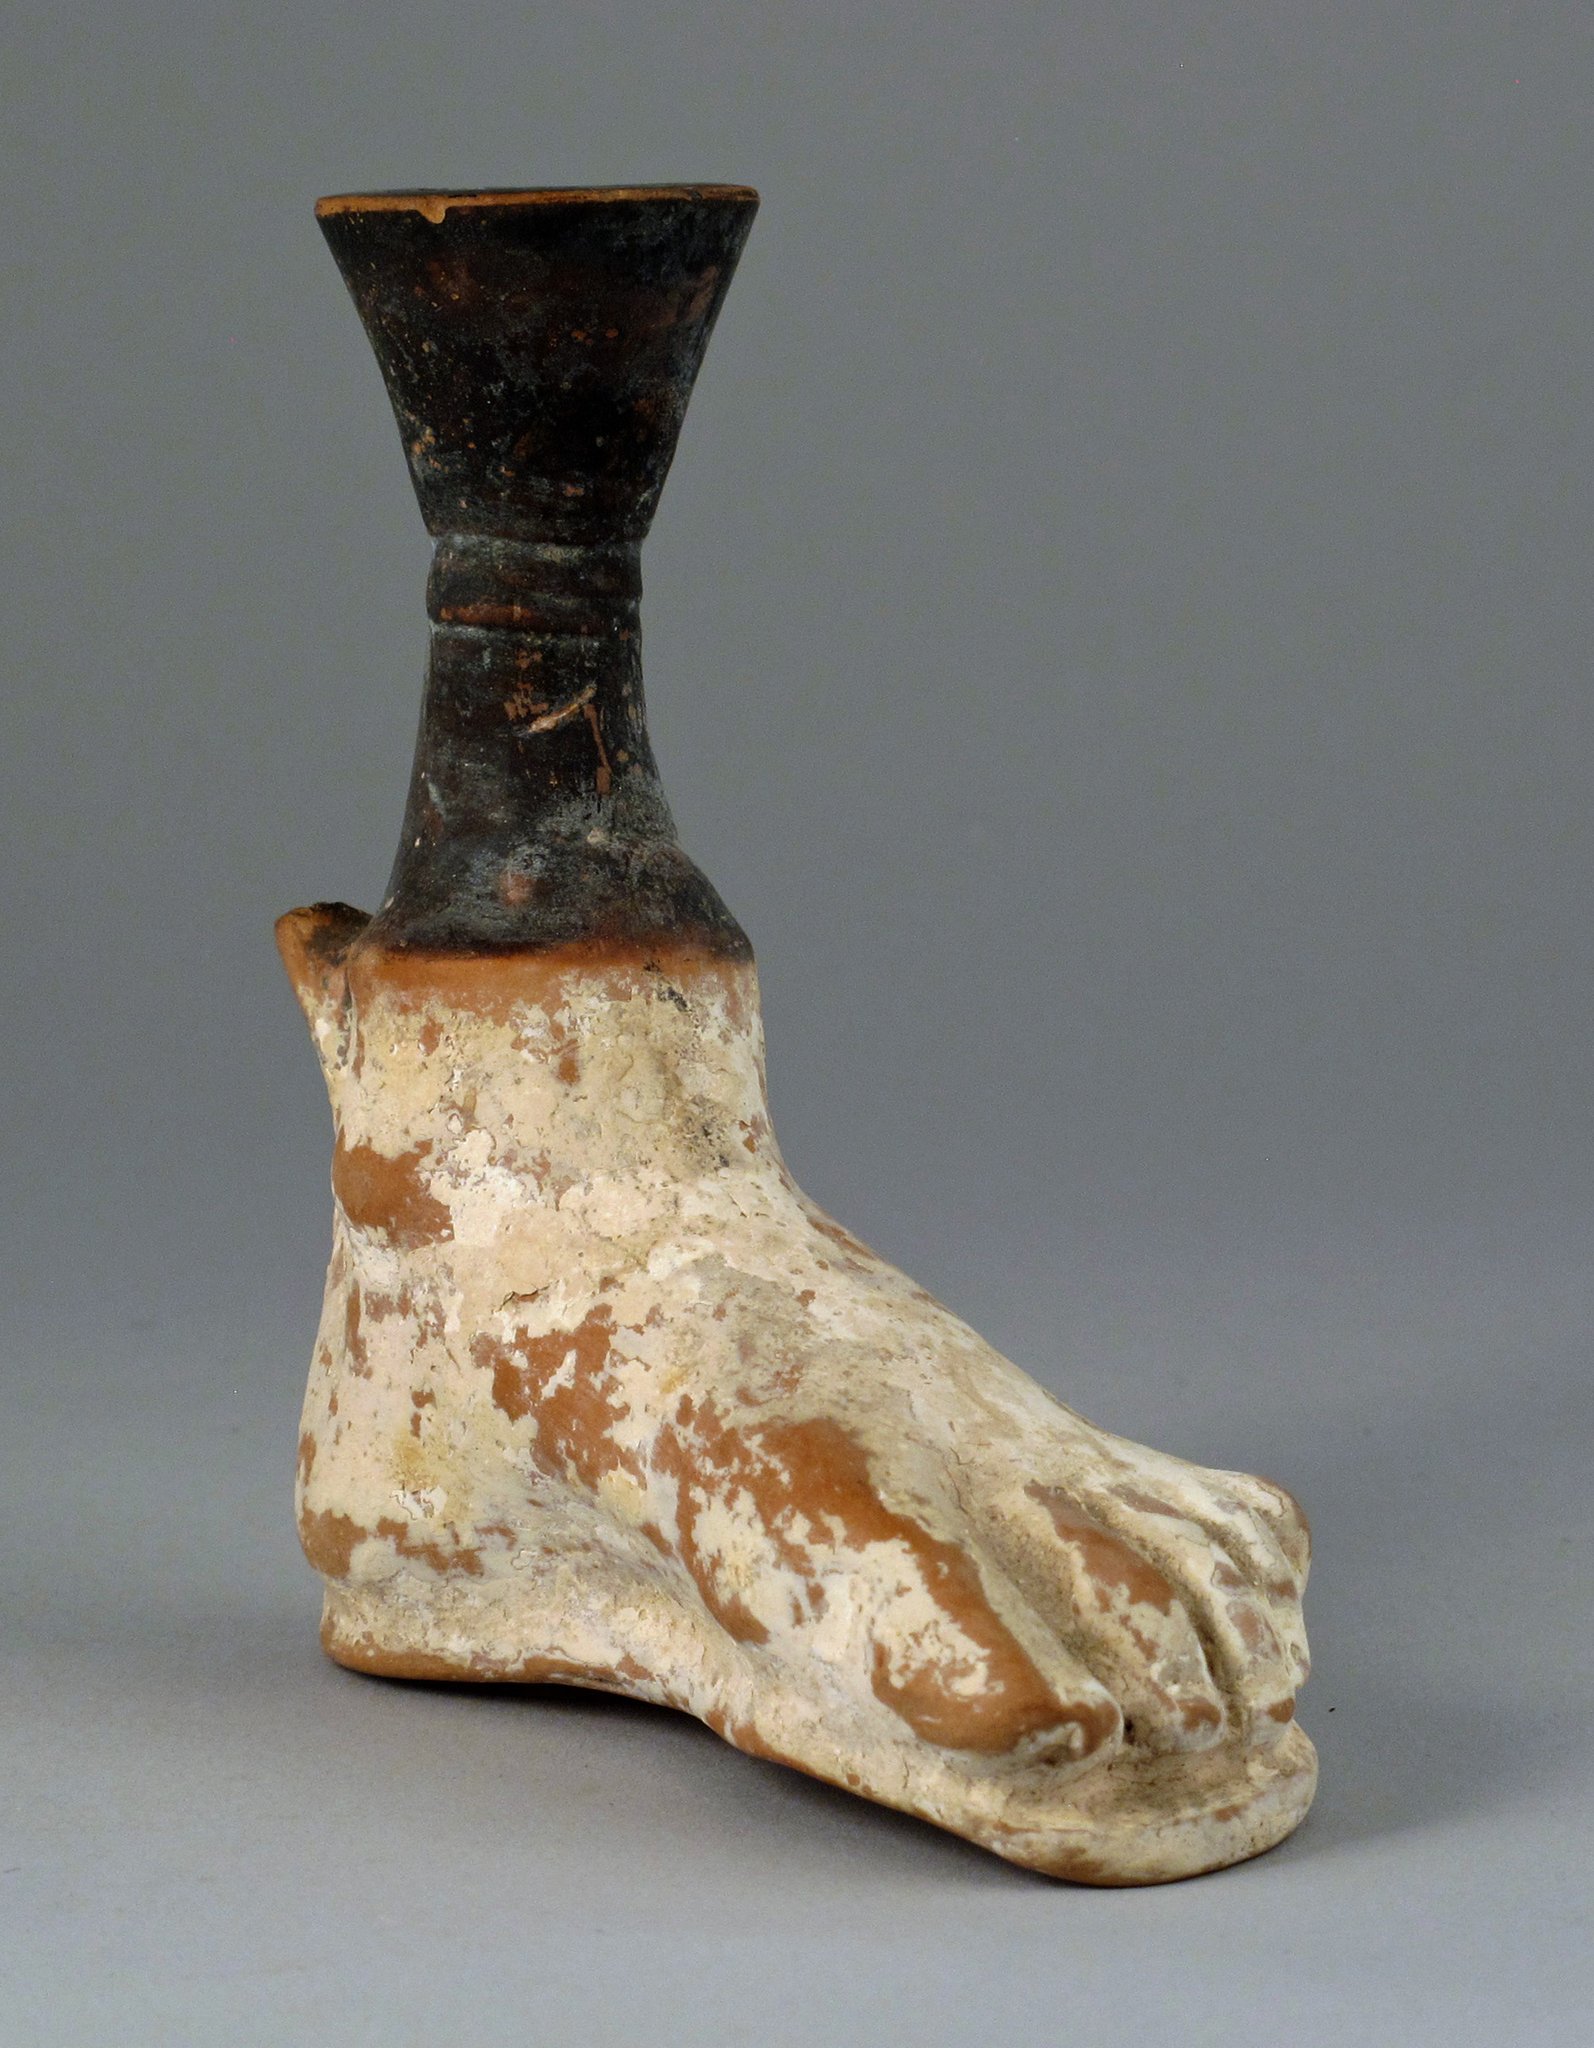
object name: aryballos in the form of a foot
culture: greek, attic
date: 400 BCE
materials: terracotta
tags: feet